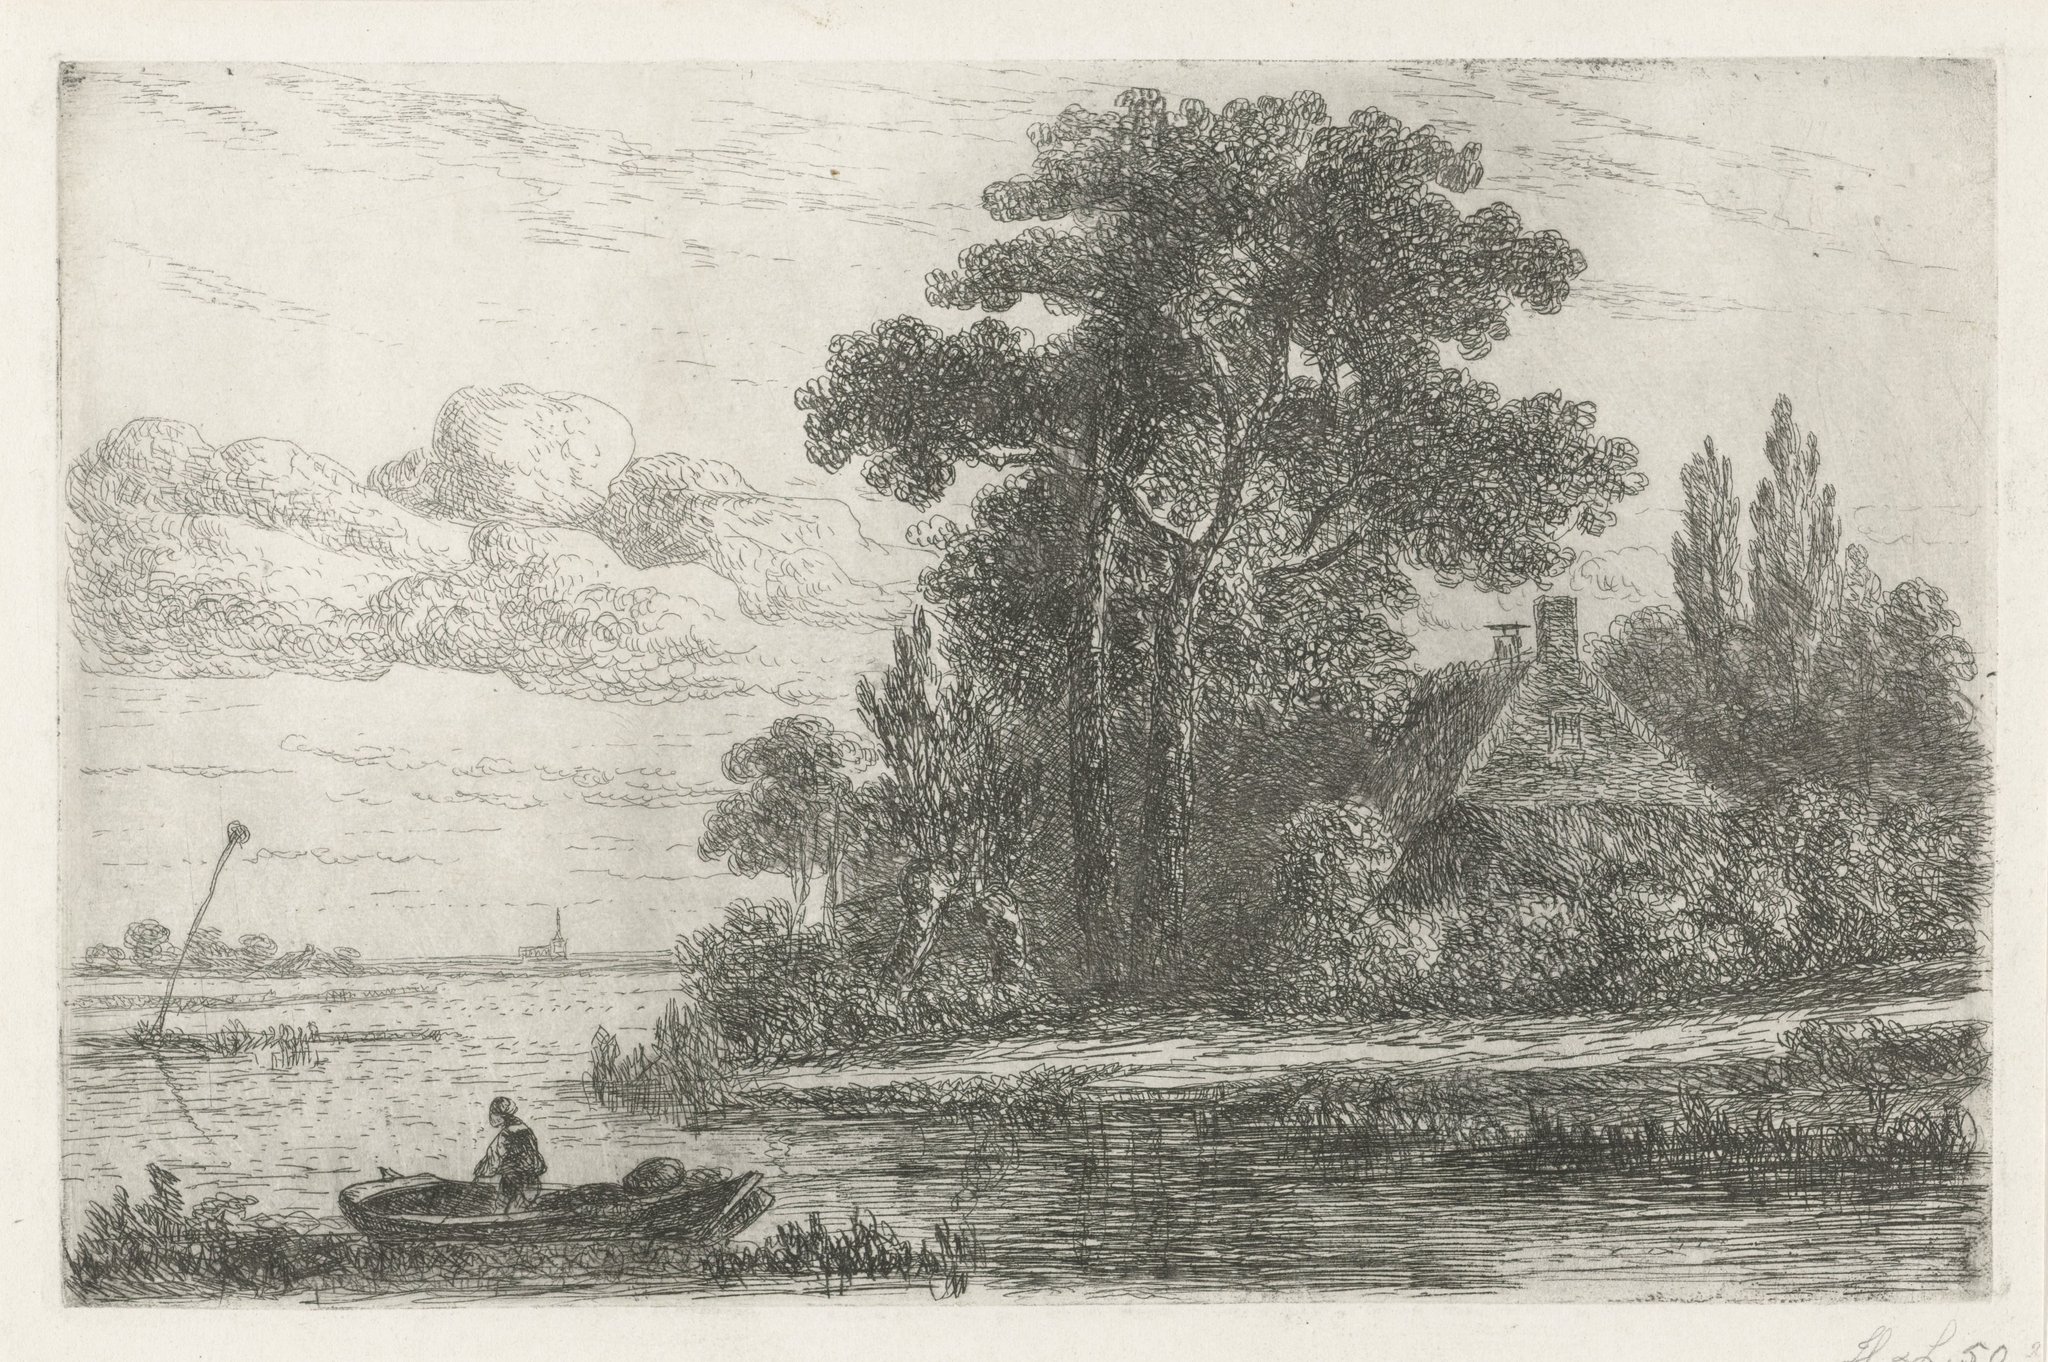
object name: print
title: Rivierlandschap met baken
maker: hermanus jan hendrik van rijkelijkhuysen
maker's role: painter, print maker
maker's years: 1813-1883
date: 1857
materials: paper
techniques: drypoint, etching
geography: utrecht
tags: river, church (exterior), rowing-boat, canoe, etc., beacon, farm or solitary house in landscape, fisherman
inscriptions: collector's mark: Lugt 2228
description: Een rivierlandschap met links een baken en op de voorgrond een visser in een boot. Rechts een boerenhoeve en op de achtergrond de contouren van een kerk.